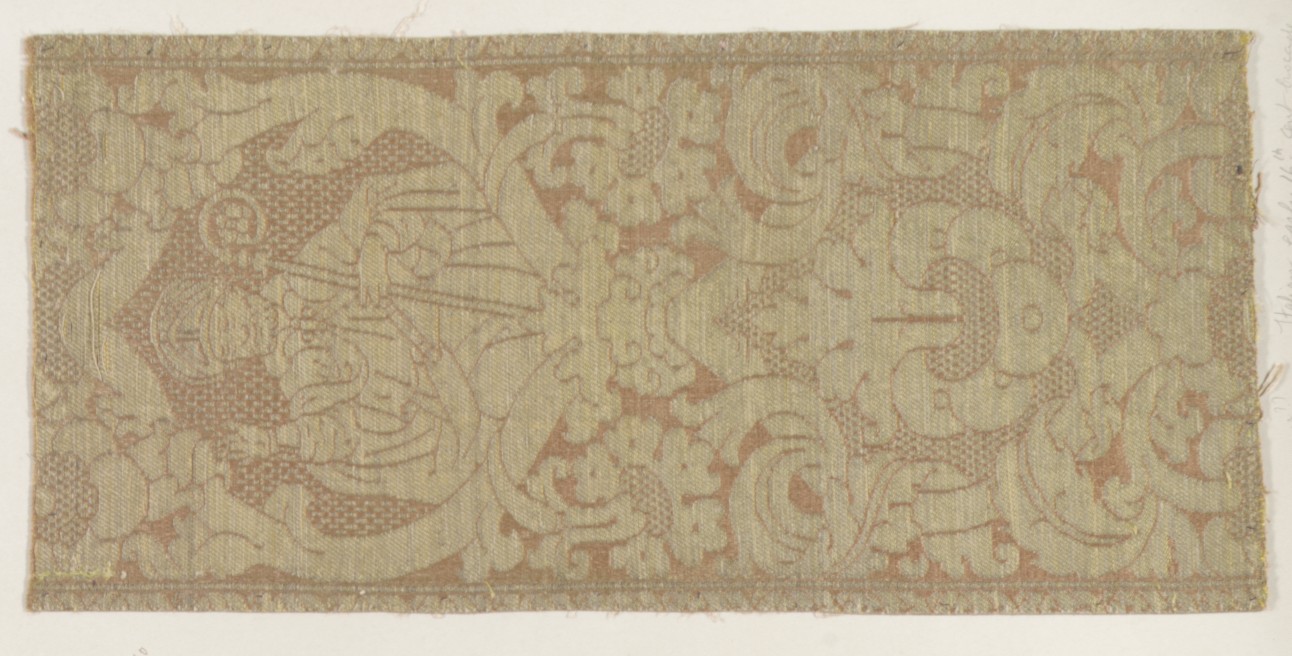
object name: fragment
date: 1501-1600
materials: metal thread, silk